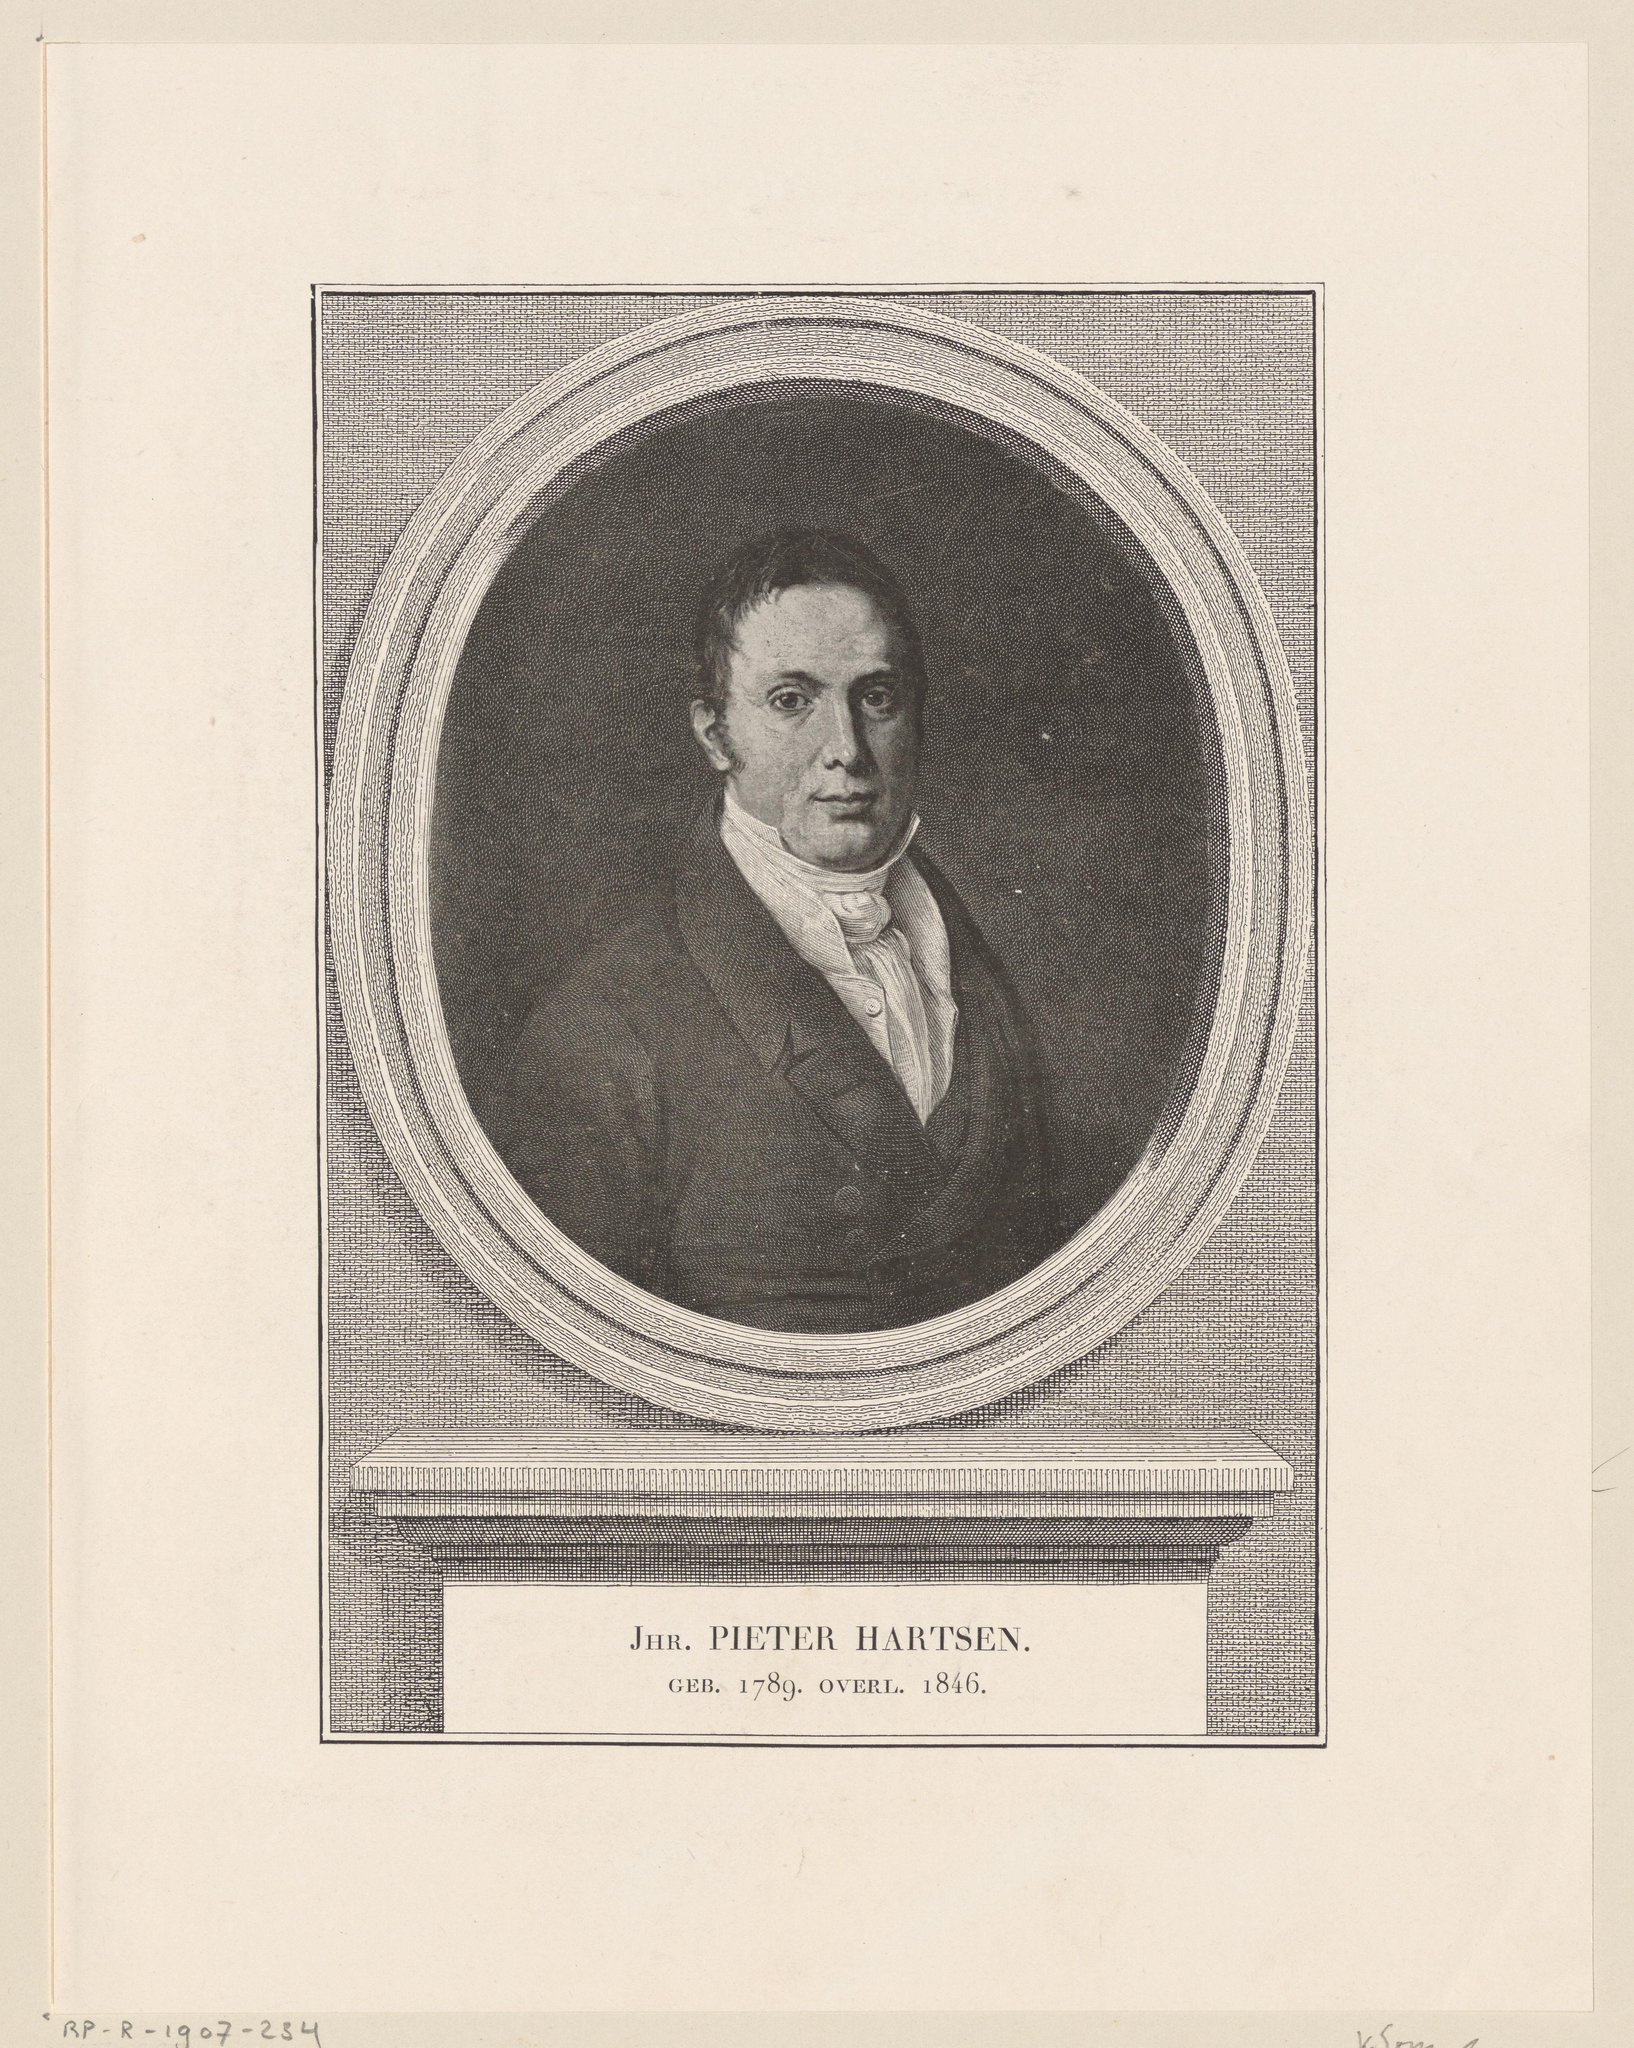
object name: photomechanical print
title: Portret van Pieter Hartsen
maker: Anonymous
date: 1900-1907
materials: paper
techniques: autotype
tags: amsterdam, historical persons, merchant, salesman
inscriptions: collector's mark: Lugt 2228